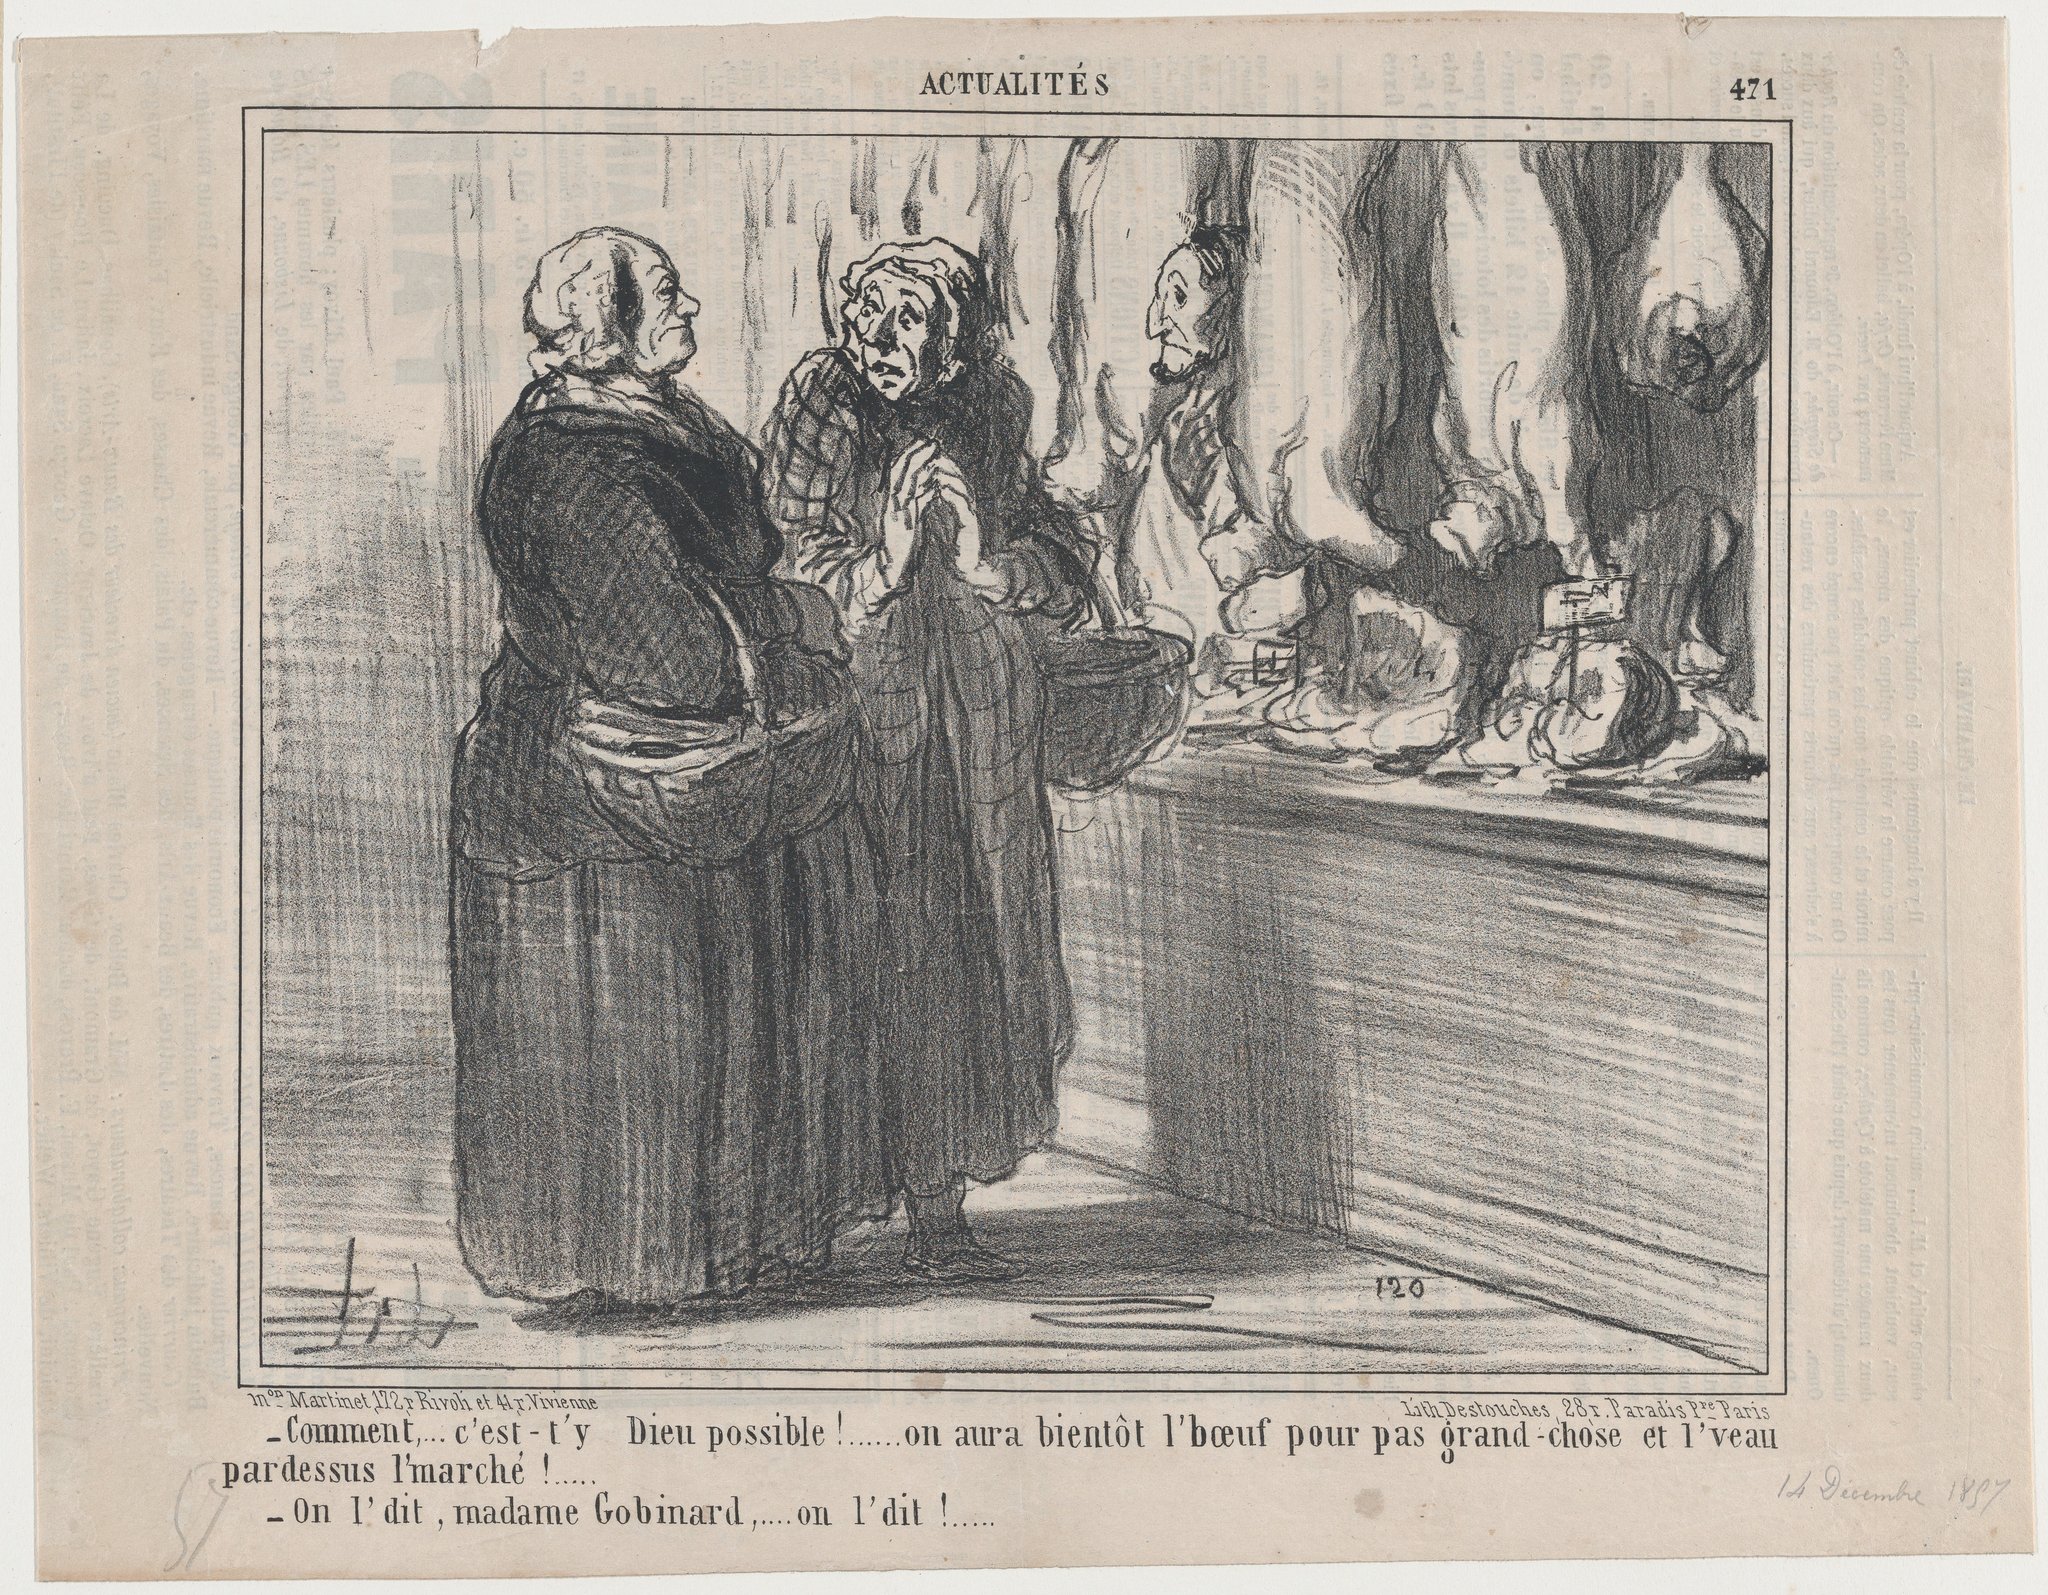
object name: print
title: Comment,...c'est-t'y Dieu possible!..., from Actualités, published in Le Charivari, December 14, 1857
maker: honoré daumier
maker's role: artist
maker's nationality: french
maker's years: 1808-1879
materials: paper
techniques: lithograph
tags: women